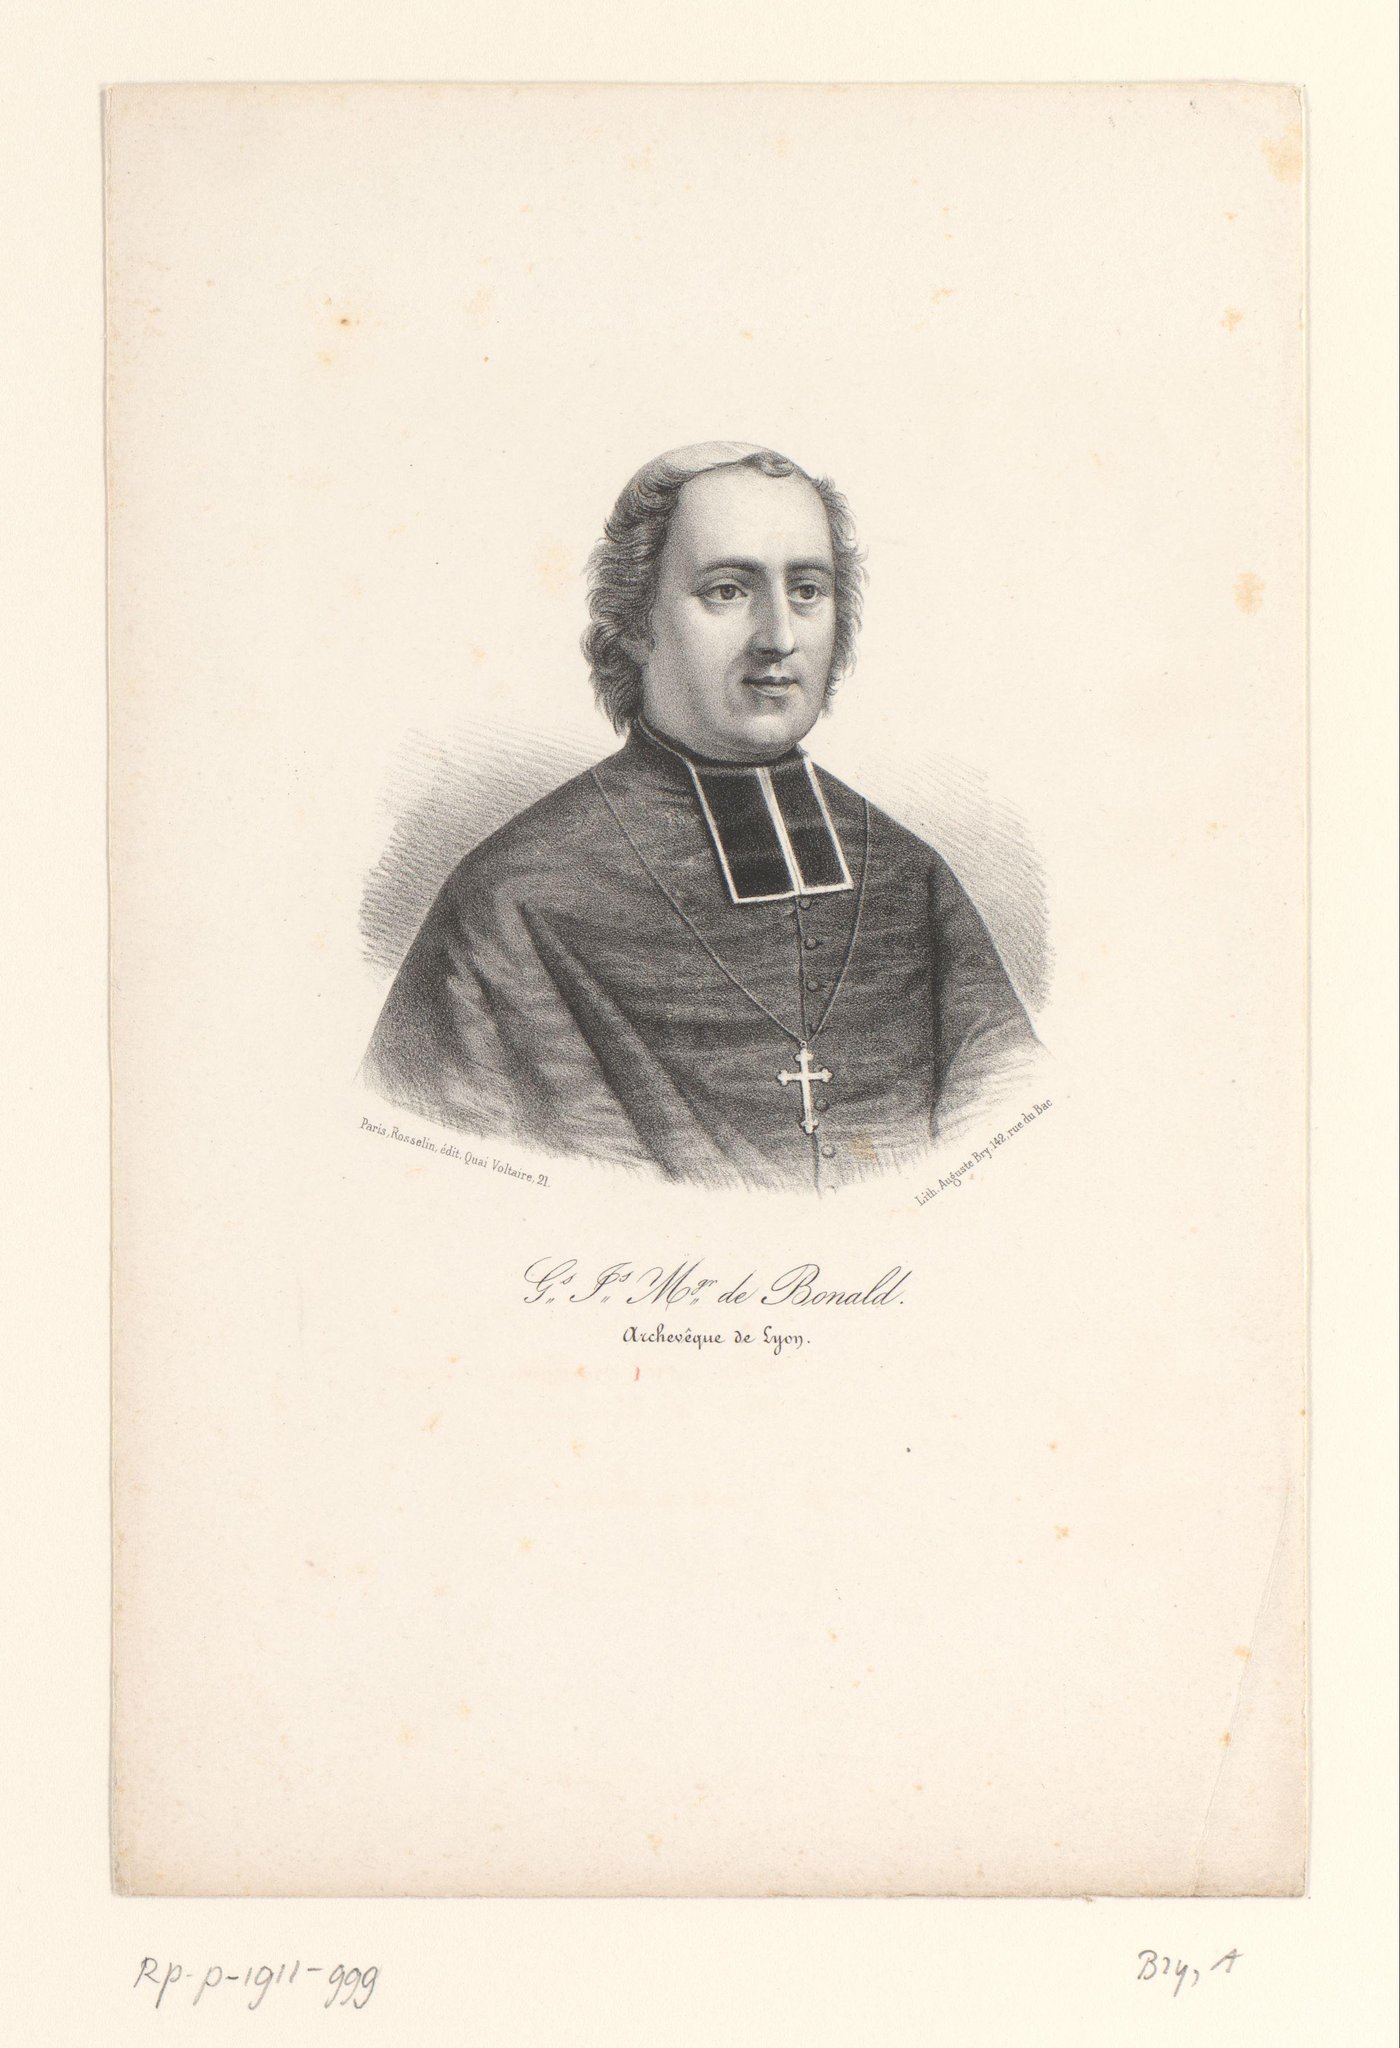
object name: print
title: Ls. Js. Mgr. de Bonald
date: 1830-1861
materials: paper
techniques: lithograph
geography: paris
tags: historical persons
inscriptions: collector's mark: Lugt 2228a